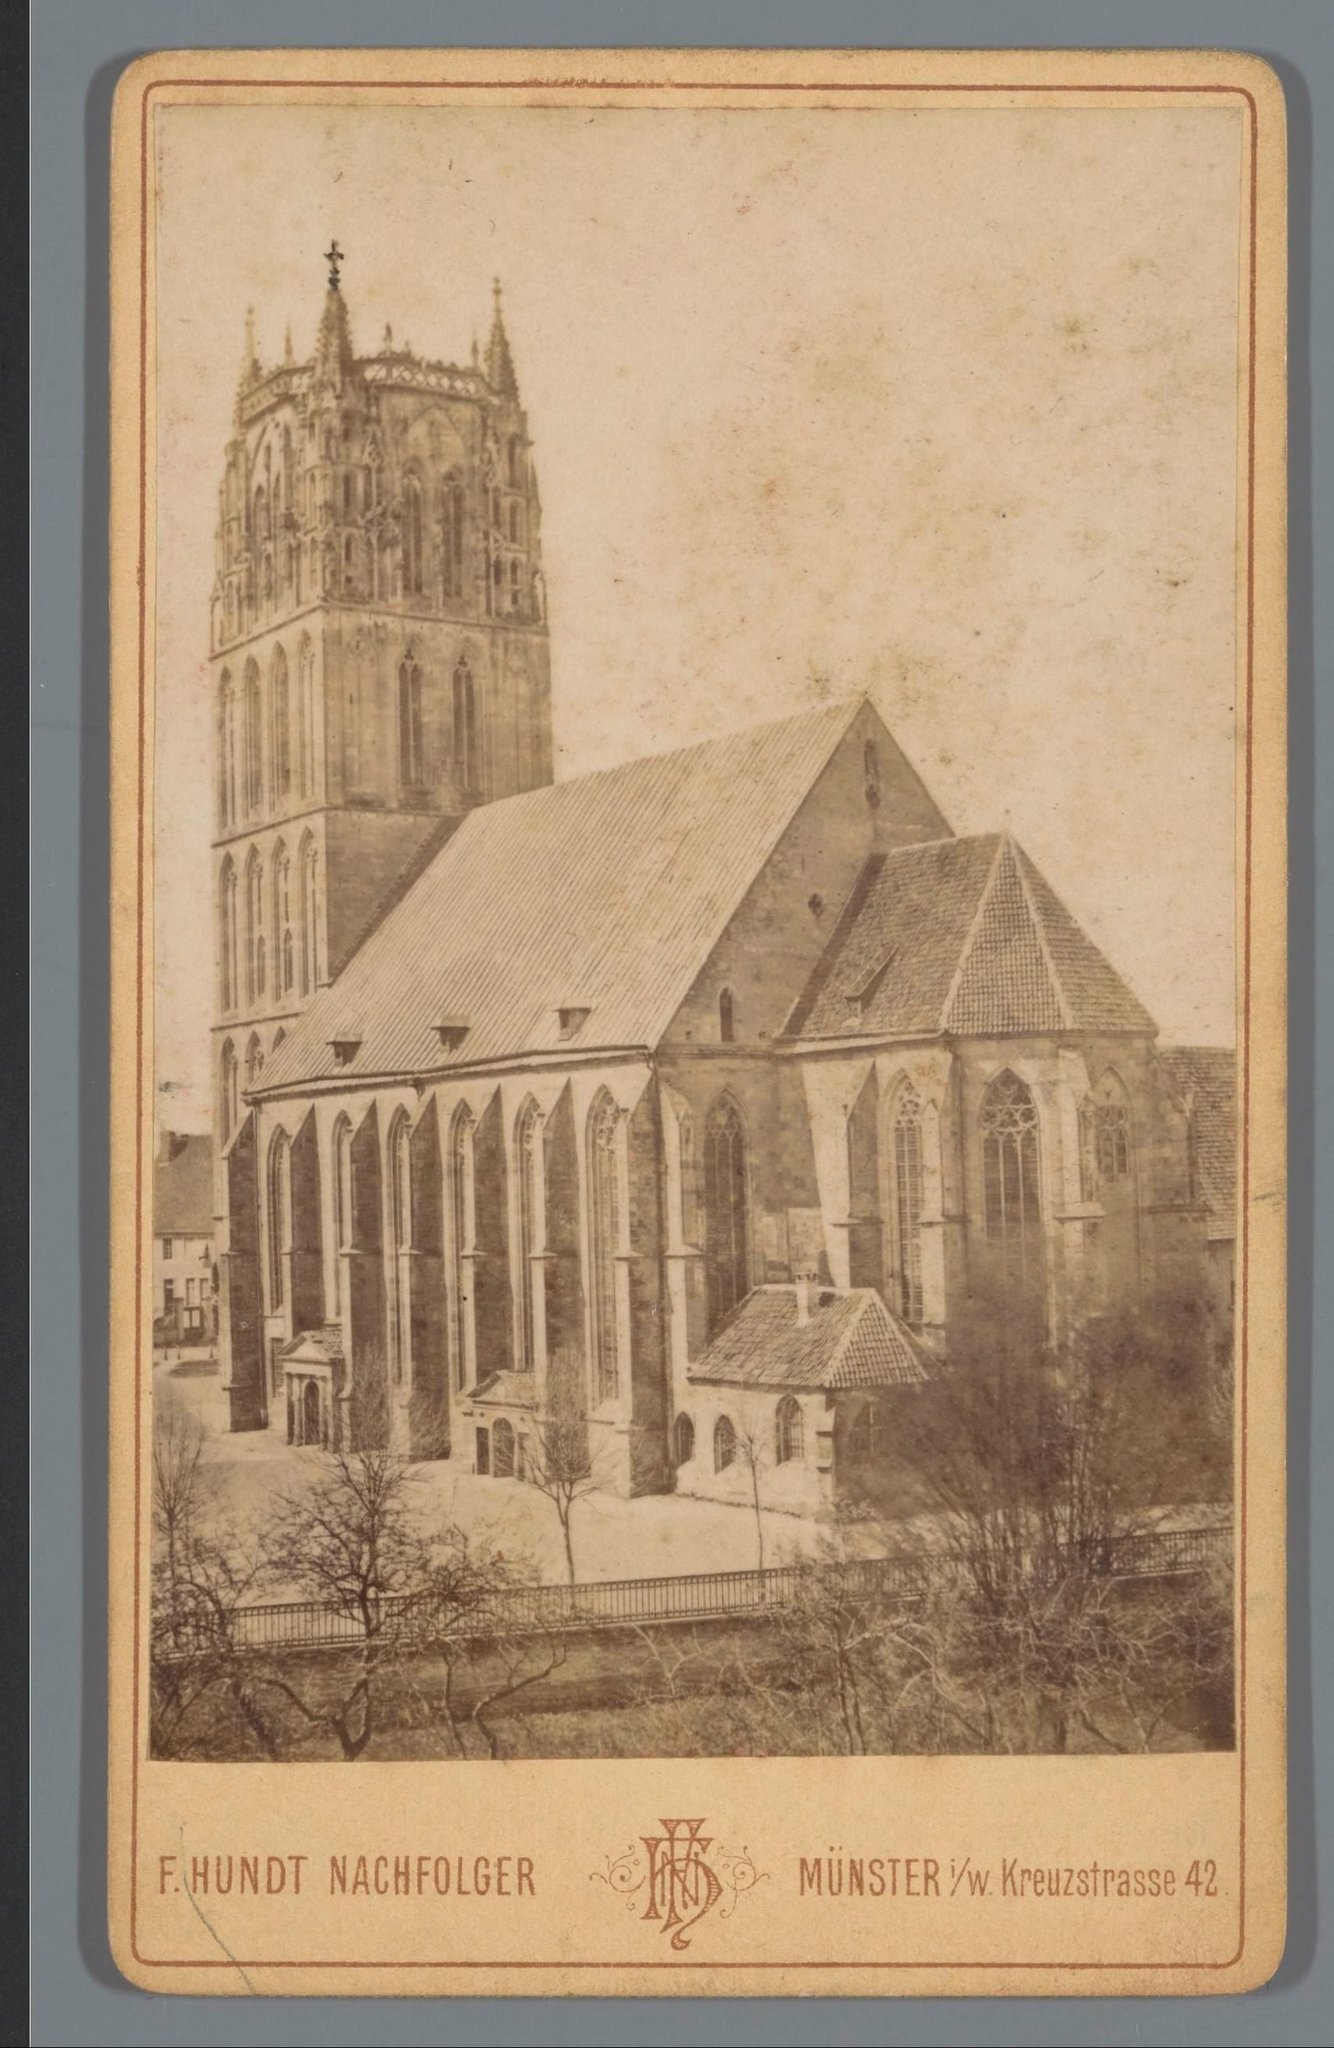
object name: photograph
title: Onze-Lieve-Vrouwekerk in Münster, Duitsland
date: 1885-1908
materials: cardboard, paper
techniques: albumen print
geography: munster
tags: church (exterior)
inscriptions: address: ‘F. HUNDT NACHFOLGER/ MÜNSTER i/W Kreuzstrasse 42’